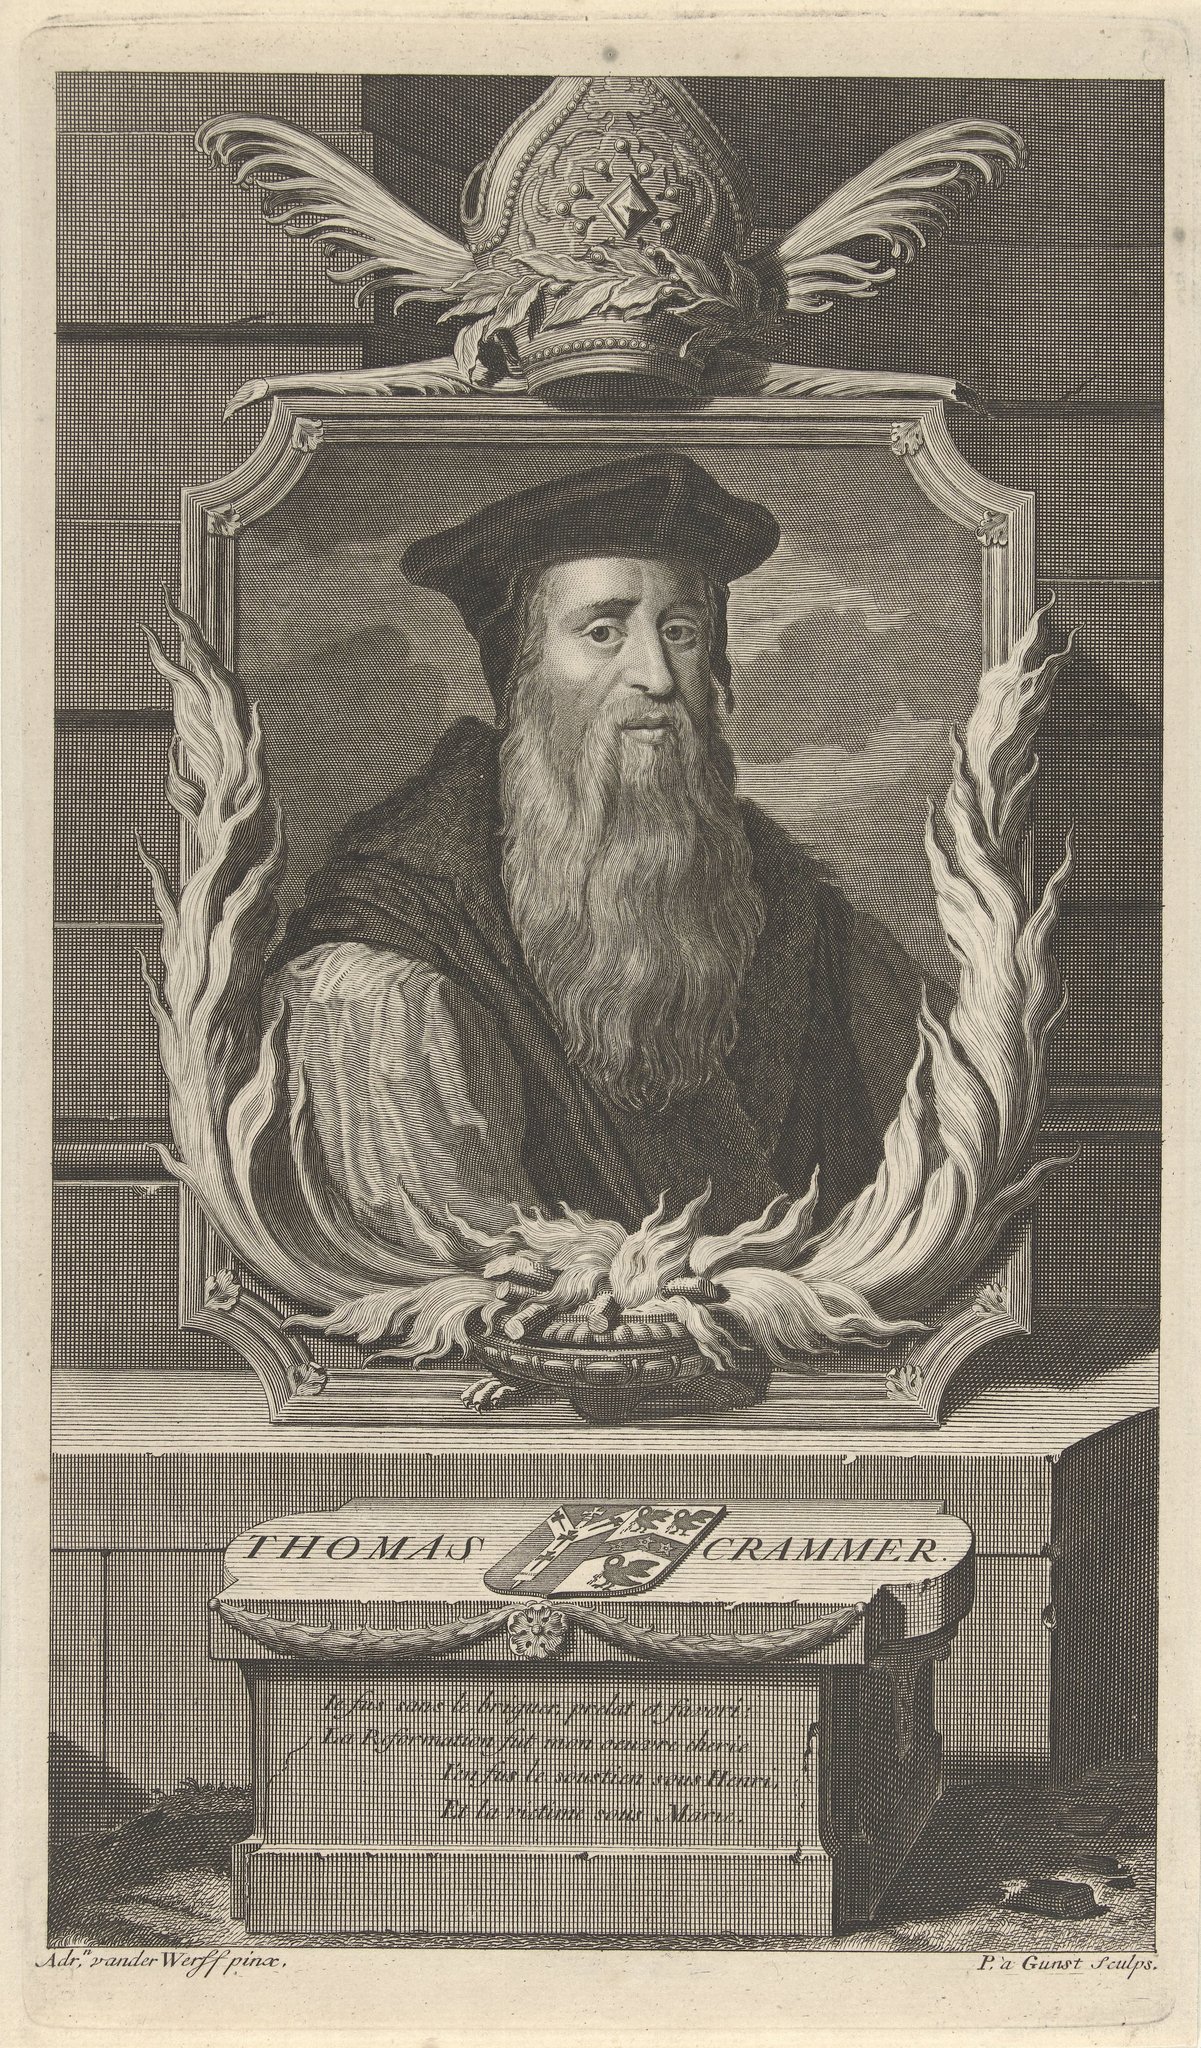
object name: print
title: Portret van aartsbisschop Thomas Cranmer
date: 1669-1731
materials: paper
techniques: engraving, etching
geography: amsterdam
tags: flame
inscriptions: collector's mark: Lugt 2228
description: Thomas Cranmer, aartsbisschop van Canterbury en protestants martelaar. De lijst van het portret is versierd met vlammen, verwijzend naar zijn marteldood. Onder het portret zijn wapenschild. De prent heeft als onderschrift een Frans gedicht over zijn leven.